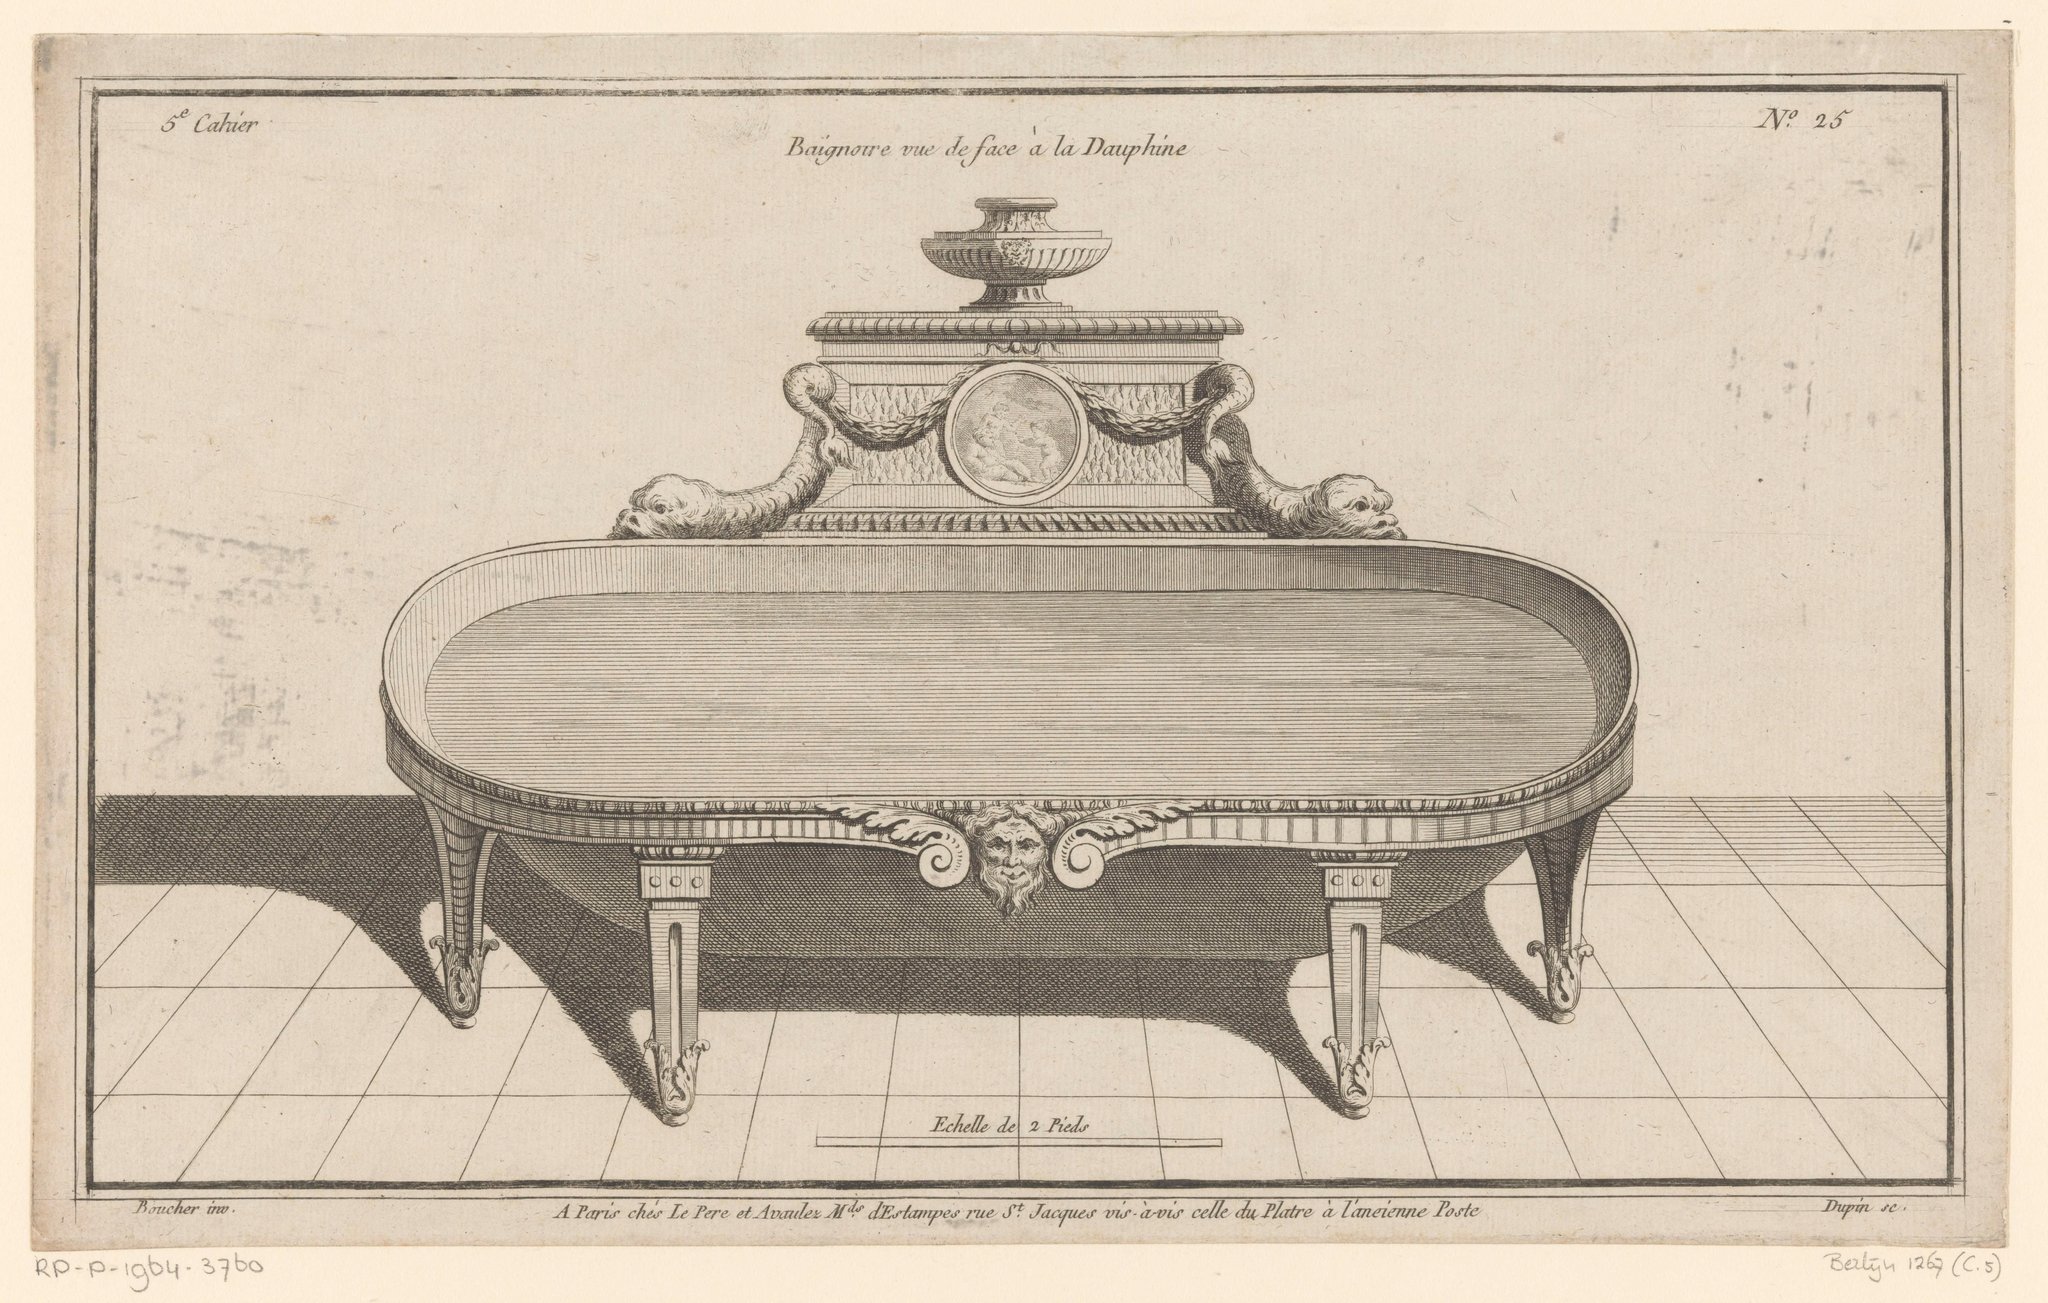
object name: ornament print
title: Baignoire vue de face à la Dauphine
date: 1772-1779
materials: paper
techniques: engraving, etching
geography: paris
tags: dolphin ~ ornament, ornament ~ medallion, mask, mascaron ~ ornament, bath-tub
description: Een geornamenteerd bad met een masker, twee dolfijnen, een rond medaillon met drie putti en een vaas. Prentnummer 25.